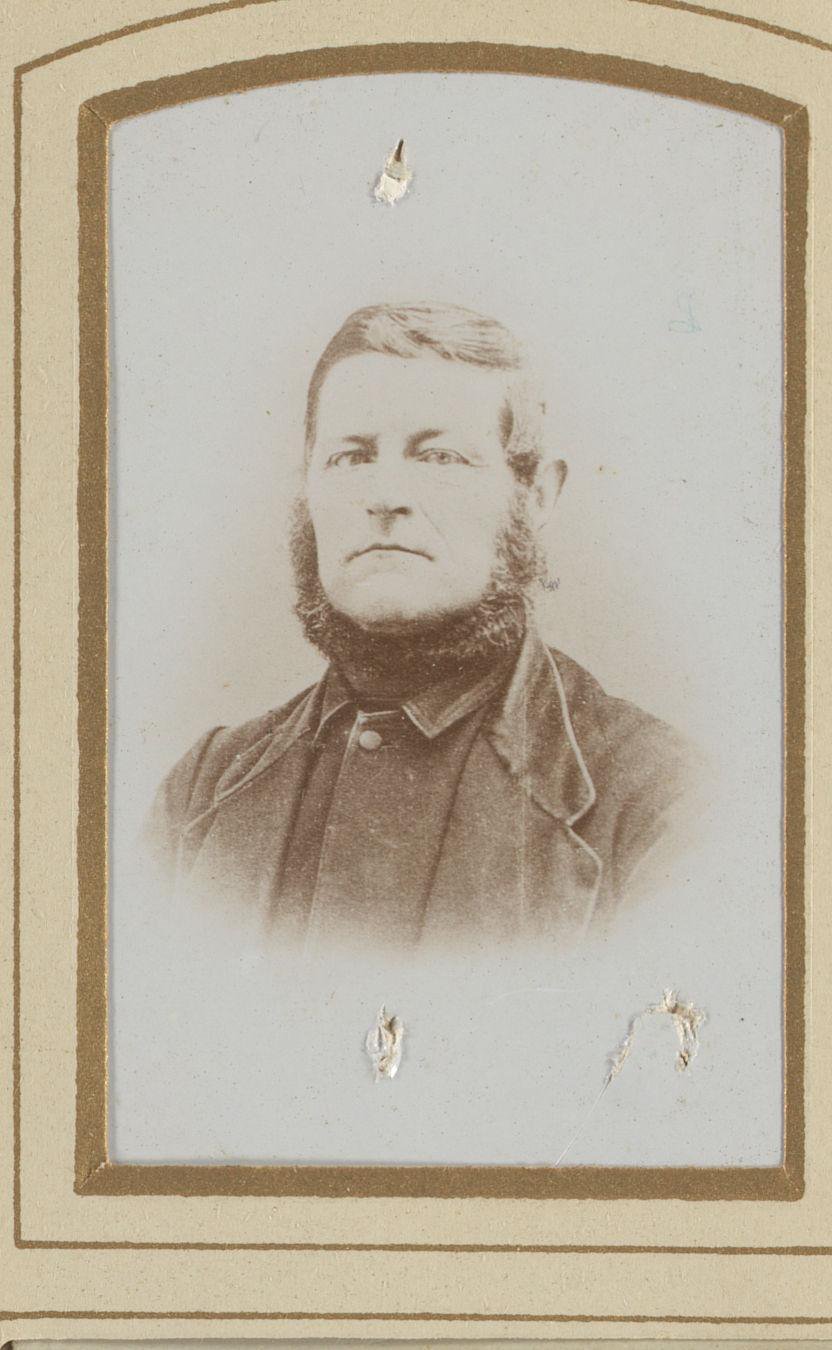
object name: photograph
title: Portret van een man met ringbaard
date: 1880-1918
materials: cardboard, photographic support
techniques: collodion silver print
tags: historical persons, beard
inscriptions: inscription: ‘Photographische/ Ateliers/ J. Siewers & Zoon/ Edam/ Hilversum./ Specialiteit in vergrootingen.’